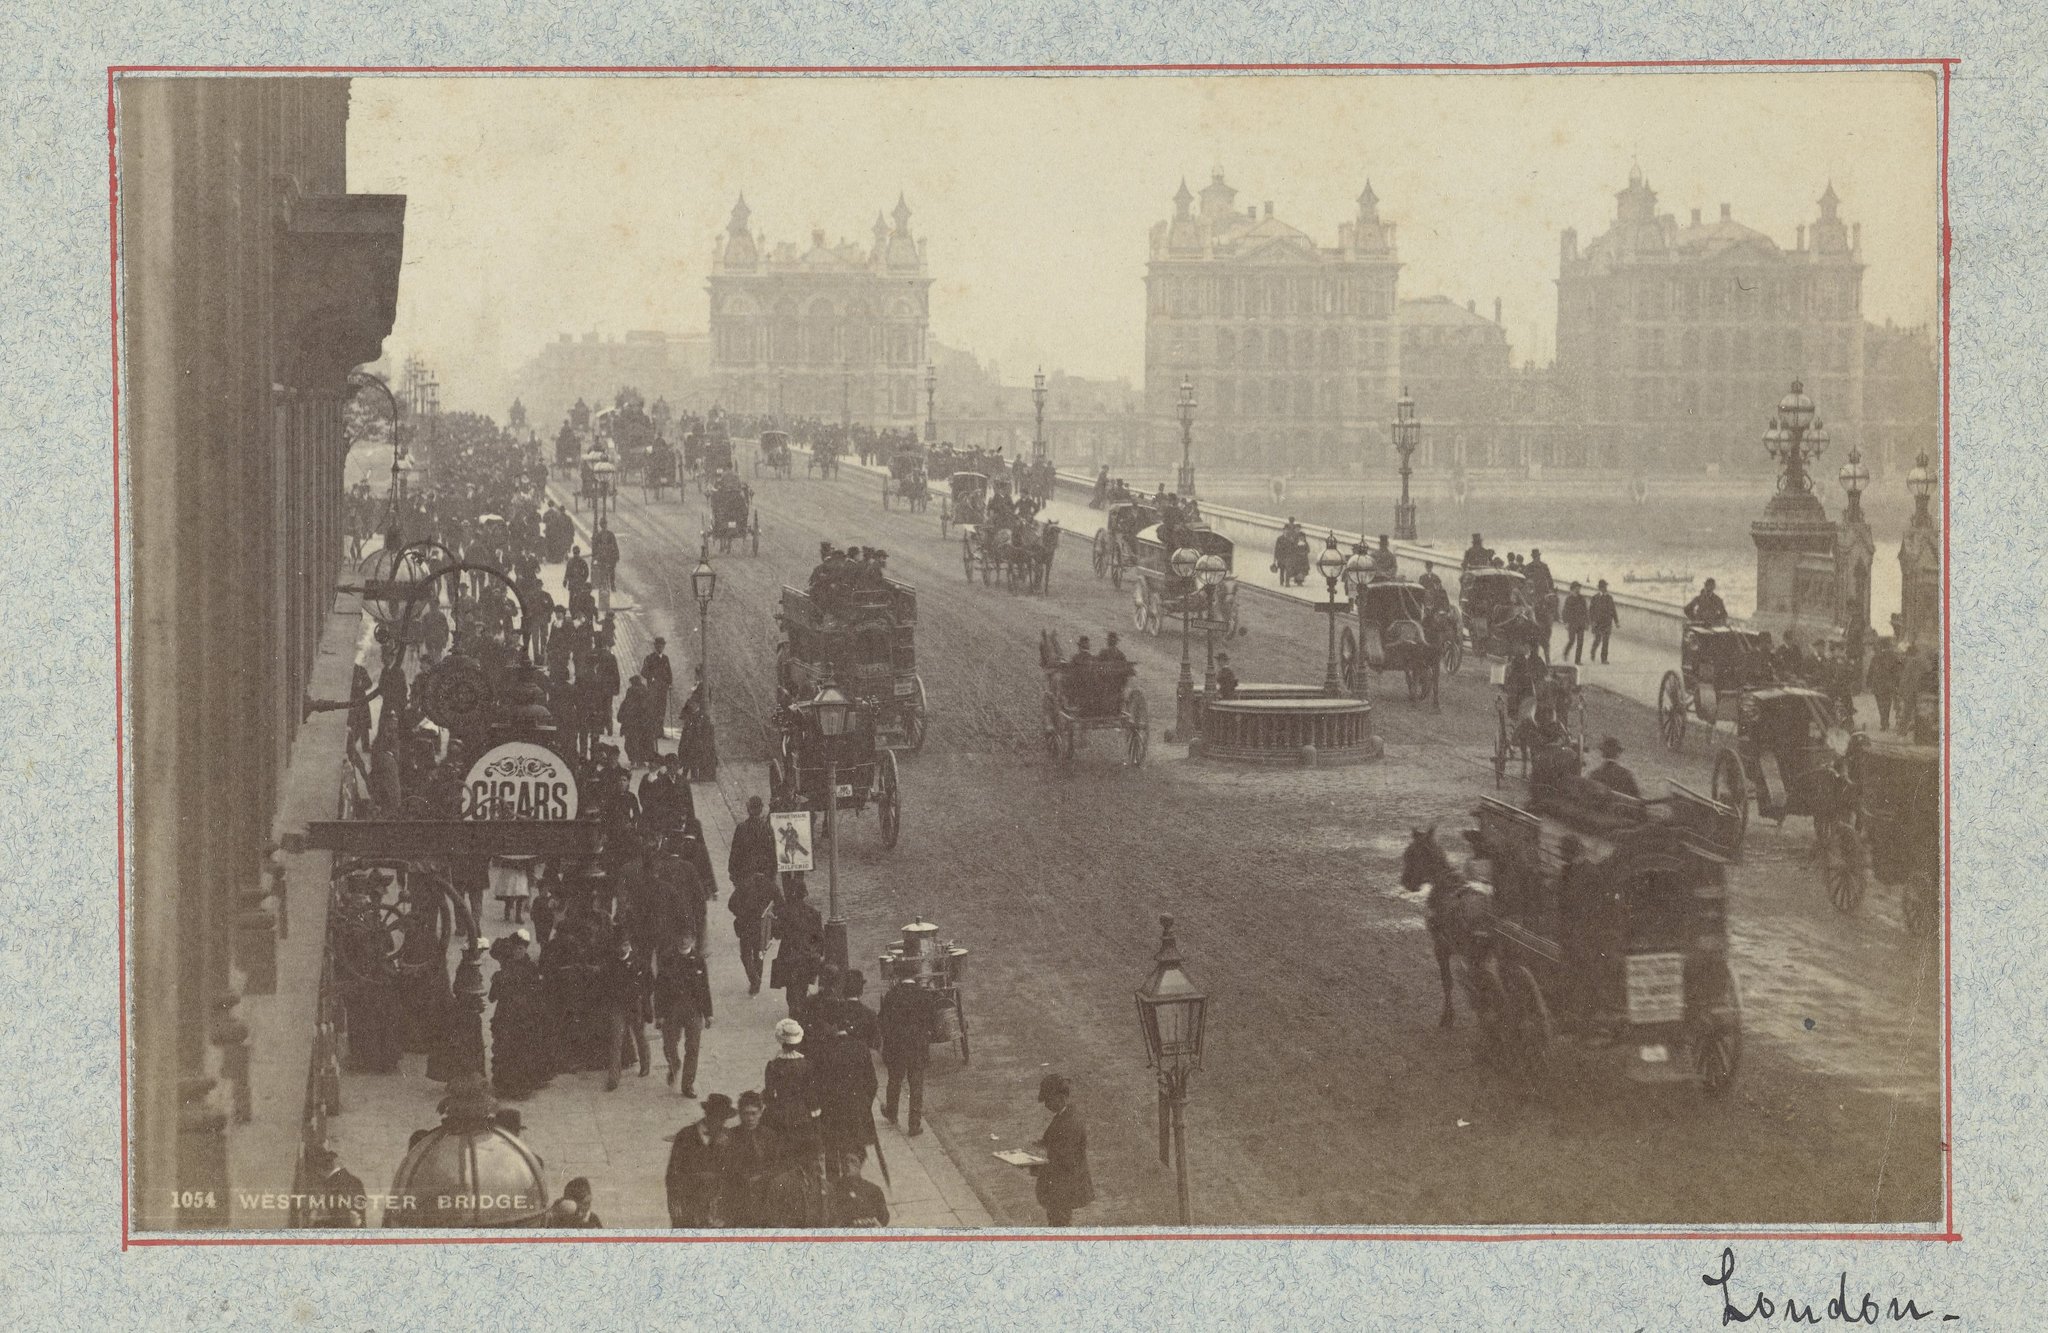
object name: photograph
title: Westminster Bridge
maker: francis godolphin osbourne stuart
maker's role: fotograaf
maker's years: 1843-1923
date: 1870-1881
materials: cardboard, paper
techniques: albumen print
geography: london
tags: bridge in city across river, canal, etc.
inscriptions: number: ‘1054’